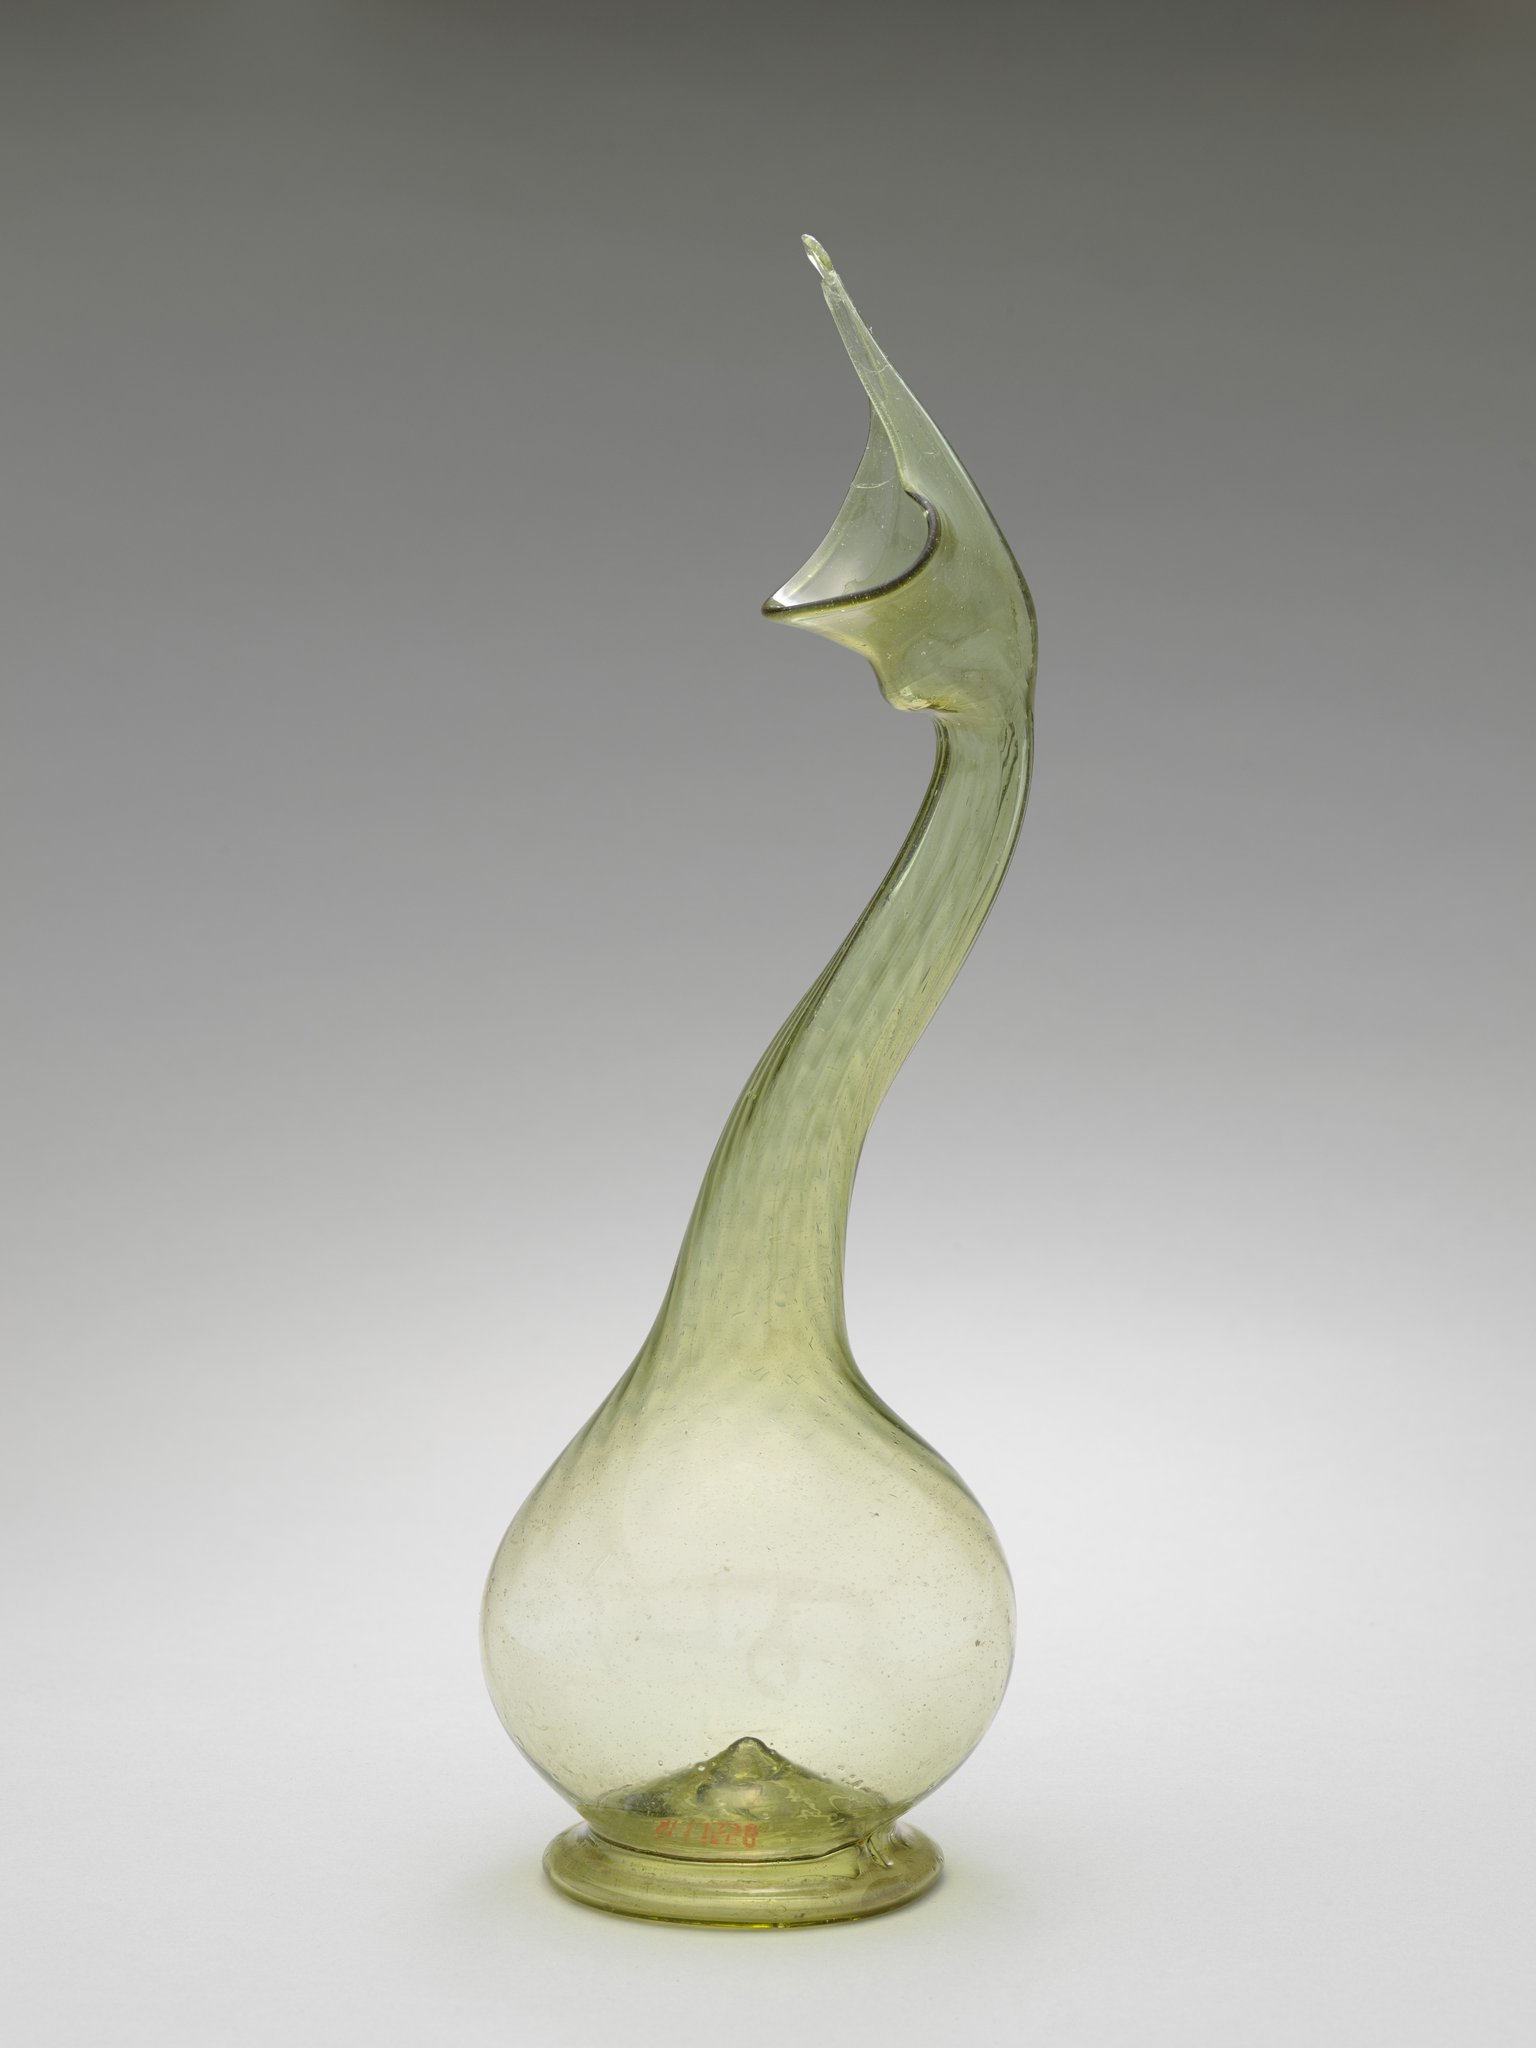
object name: bottle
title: Swan-Neck Bottle (Ashkdan)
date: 1701-1900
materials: glass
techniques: glassblowing, tooling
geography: iran